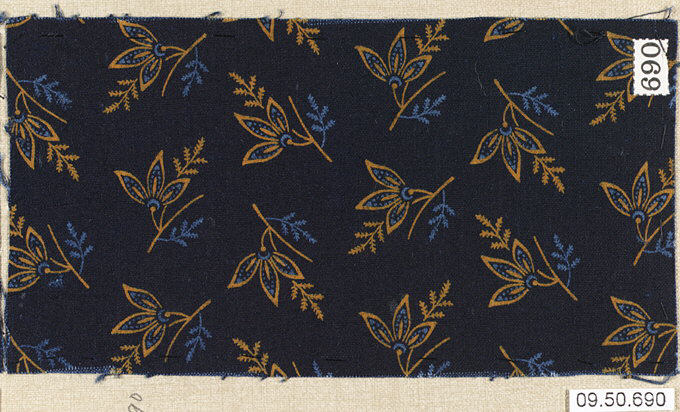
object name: piece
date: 1801-1900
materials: cotton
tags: flowers,leaves